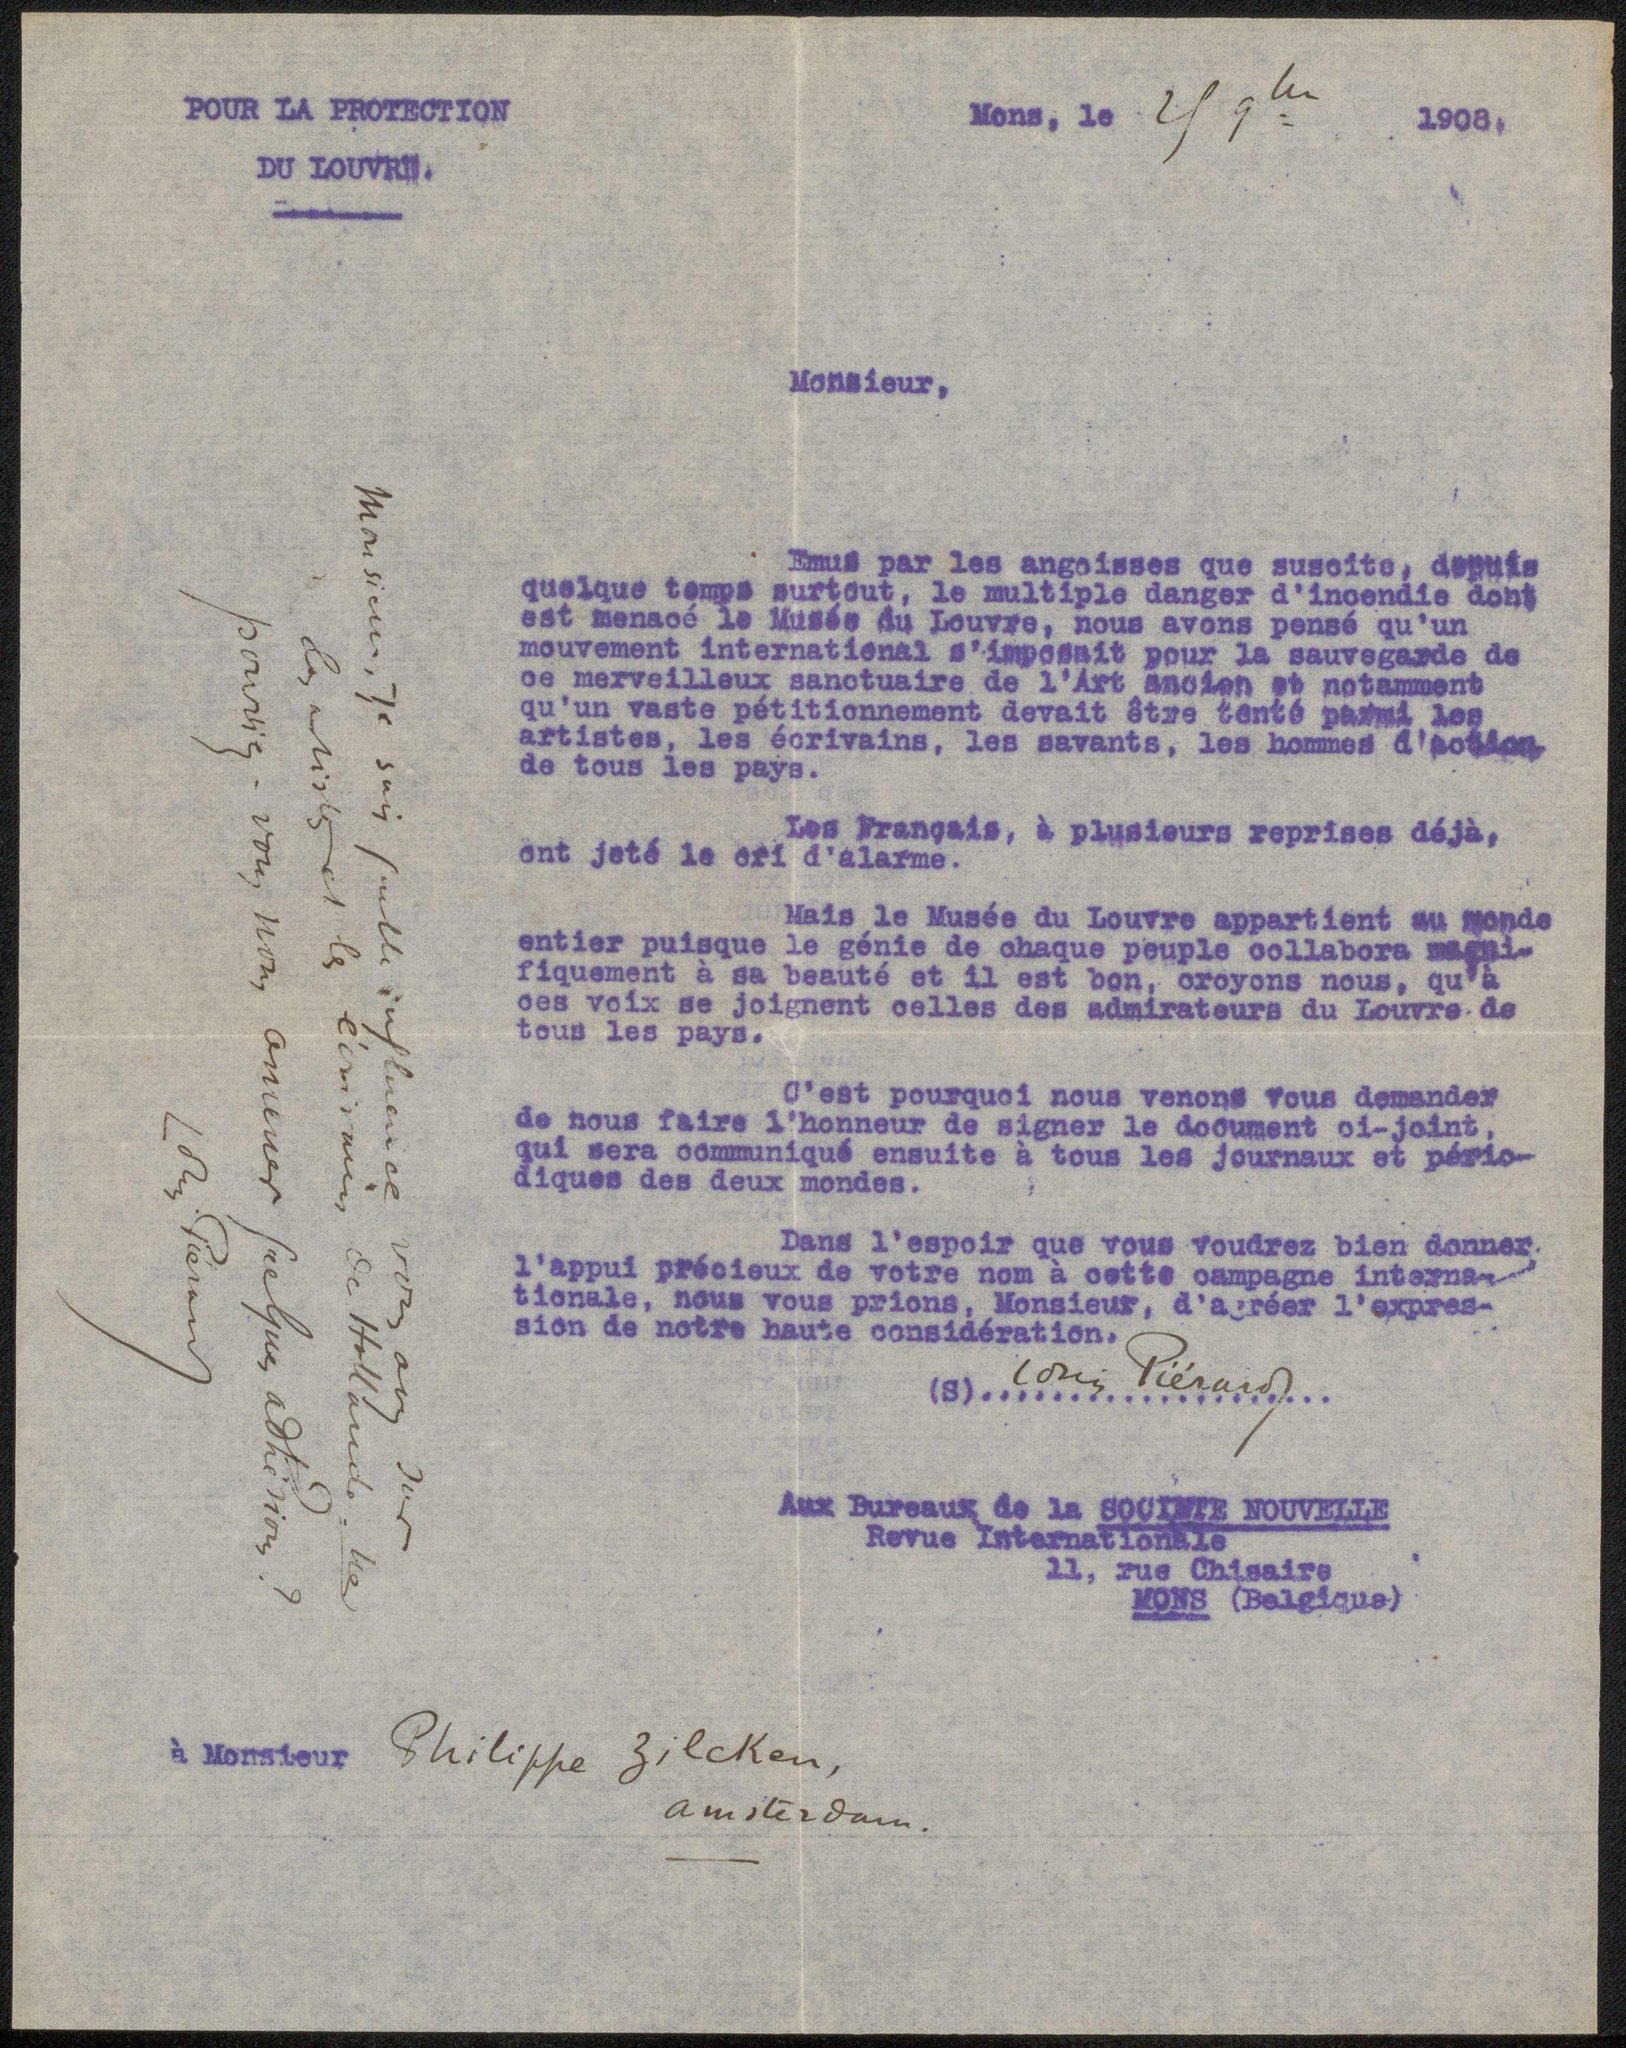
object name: letter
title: Brief aan Philip Zilcken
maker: louis piérard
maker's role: letterkundige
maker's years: 1886-1951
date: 1908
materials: ink, paper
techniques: pen, typewriting, writing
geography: bergen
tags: the hague, painter, draughtsman, philip zilcken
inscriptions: collector's mark: ‘RPK’